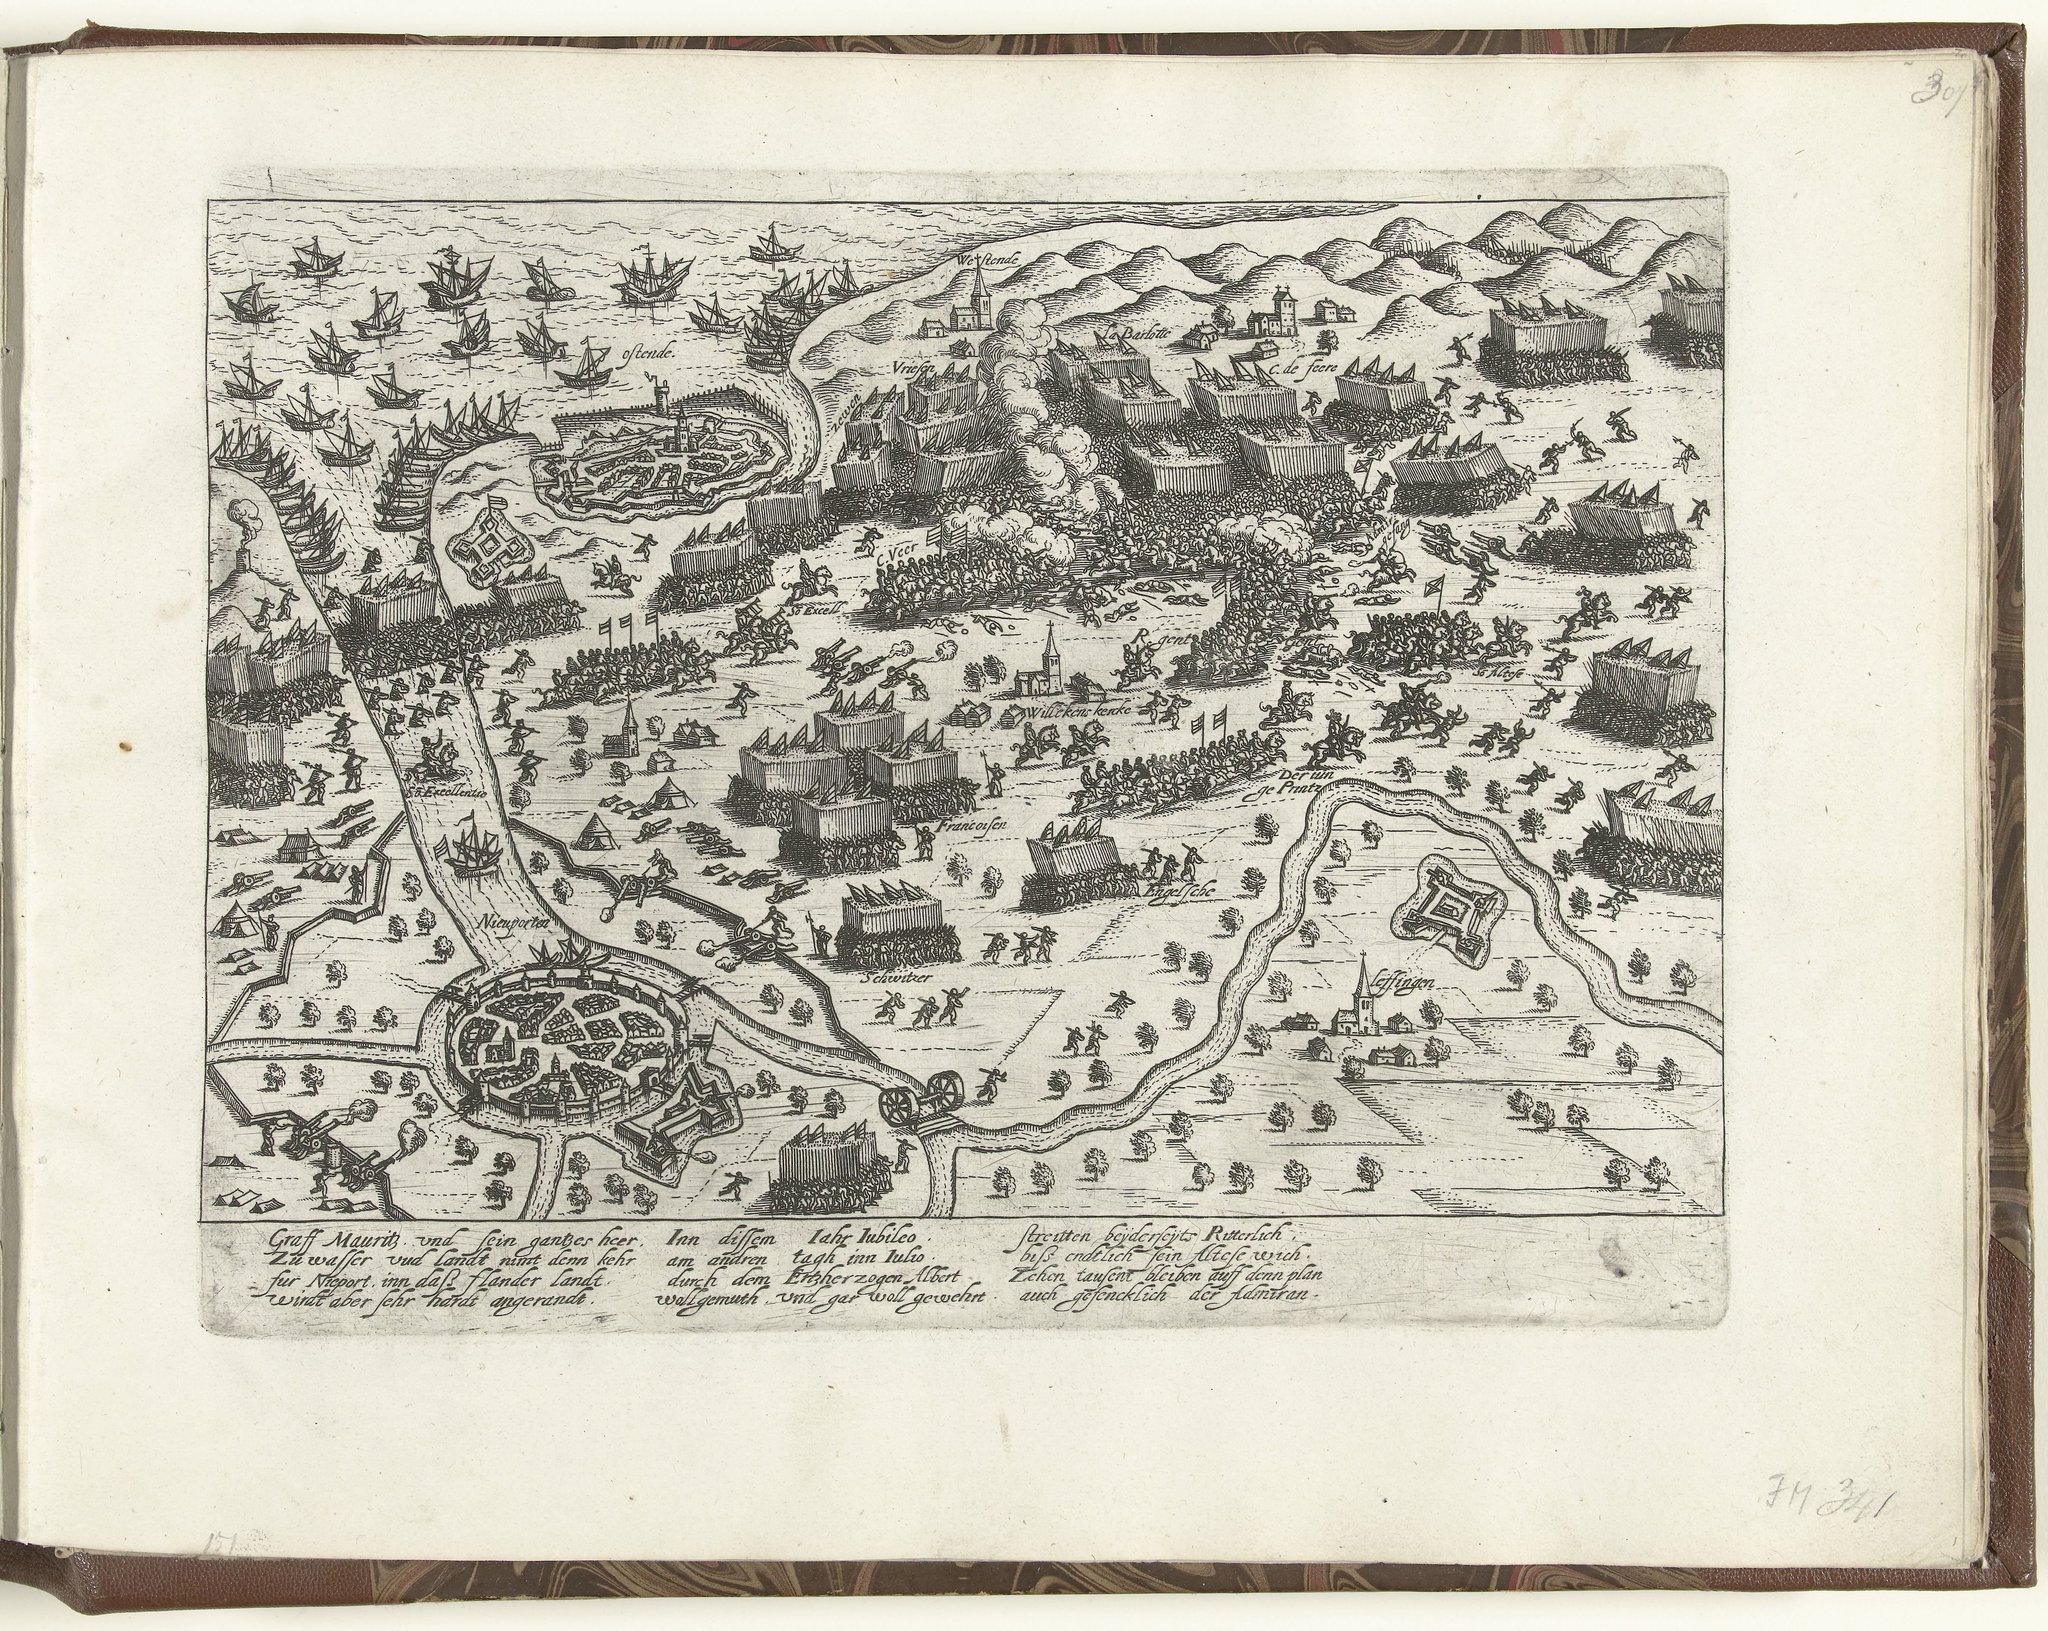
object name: print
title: Serie 10: Nederlandse en Buitenlandse Gebeurtenissen, 1587-1612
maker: frans hogenberg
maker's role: print maker, publisher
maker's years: 1538-1590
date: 1600-1602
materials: paper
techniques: etching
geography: cologne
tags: battle, fighting in general, battle of nieuwpoort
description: Gezicht op de slag bij Nieuwpoort, 2 juli 1600. Linksonder Nieuwpoort, boven Oostende. Met onderschrift van 12 regels in het Duits. Ongenummerd.